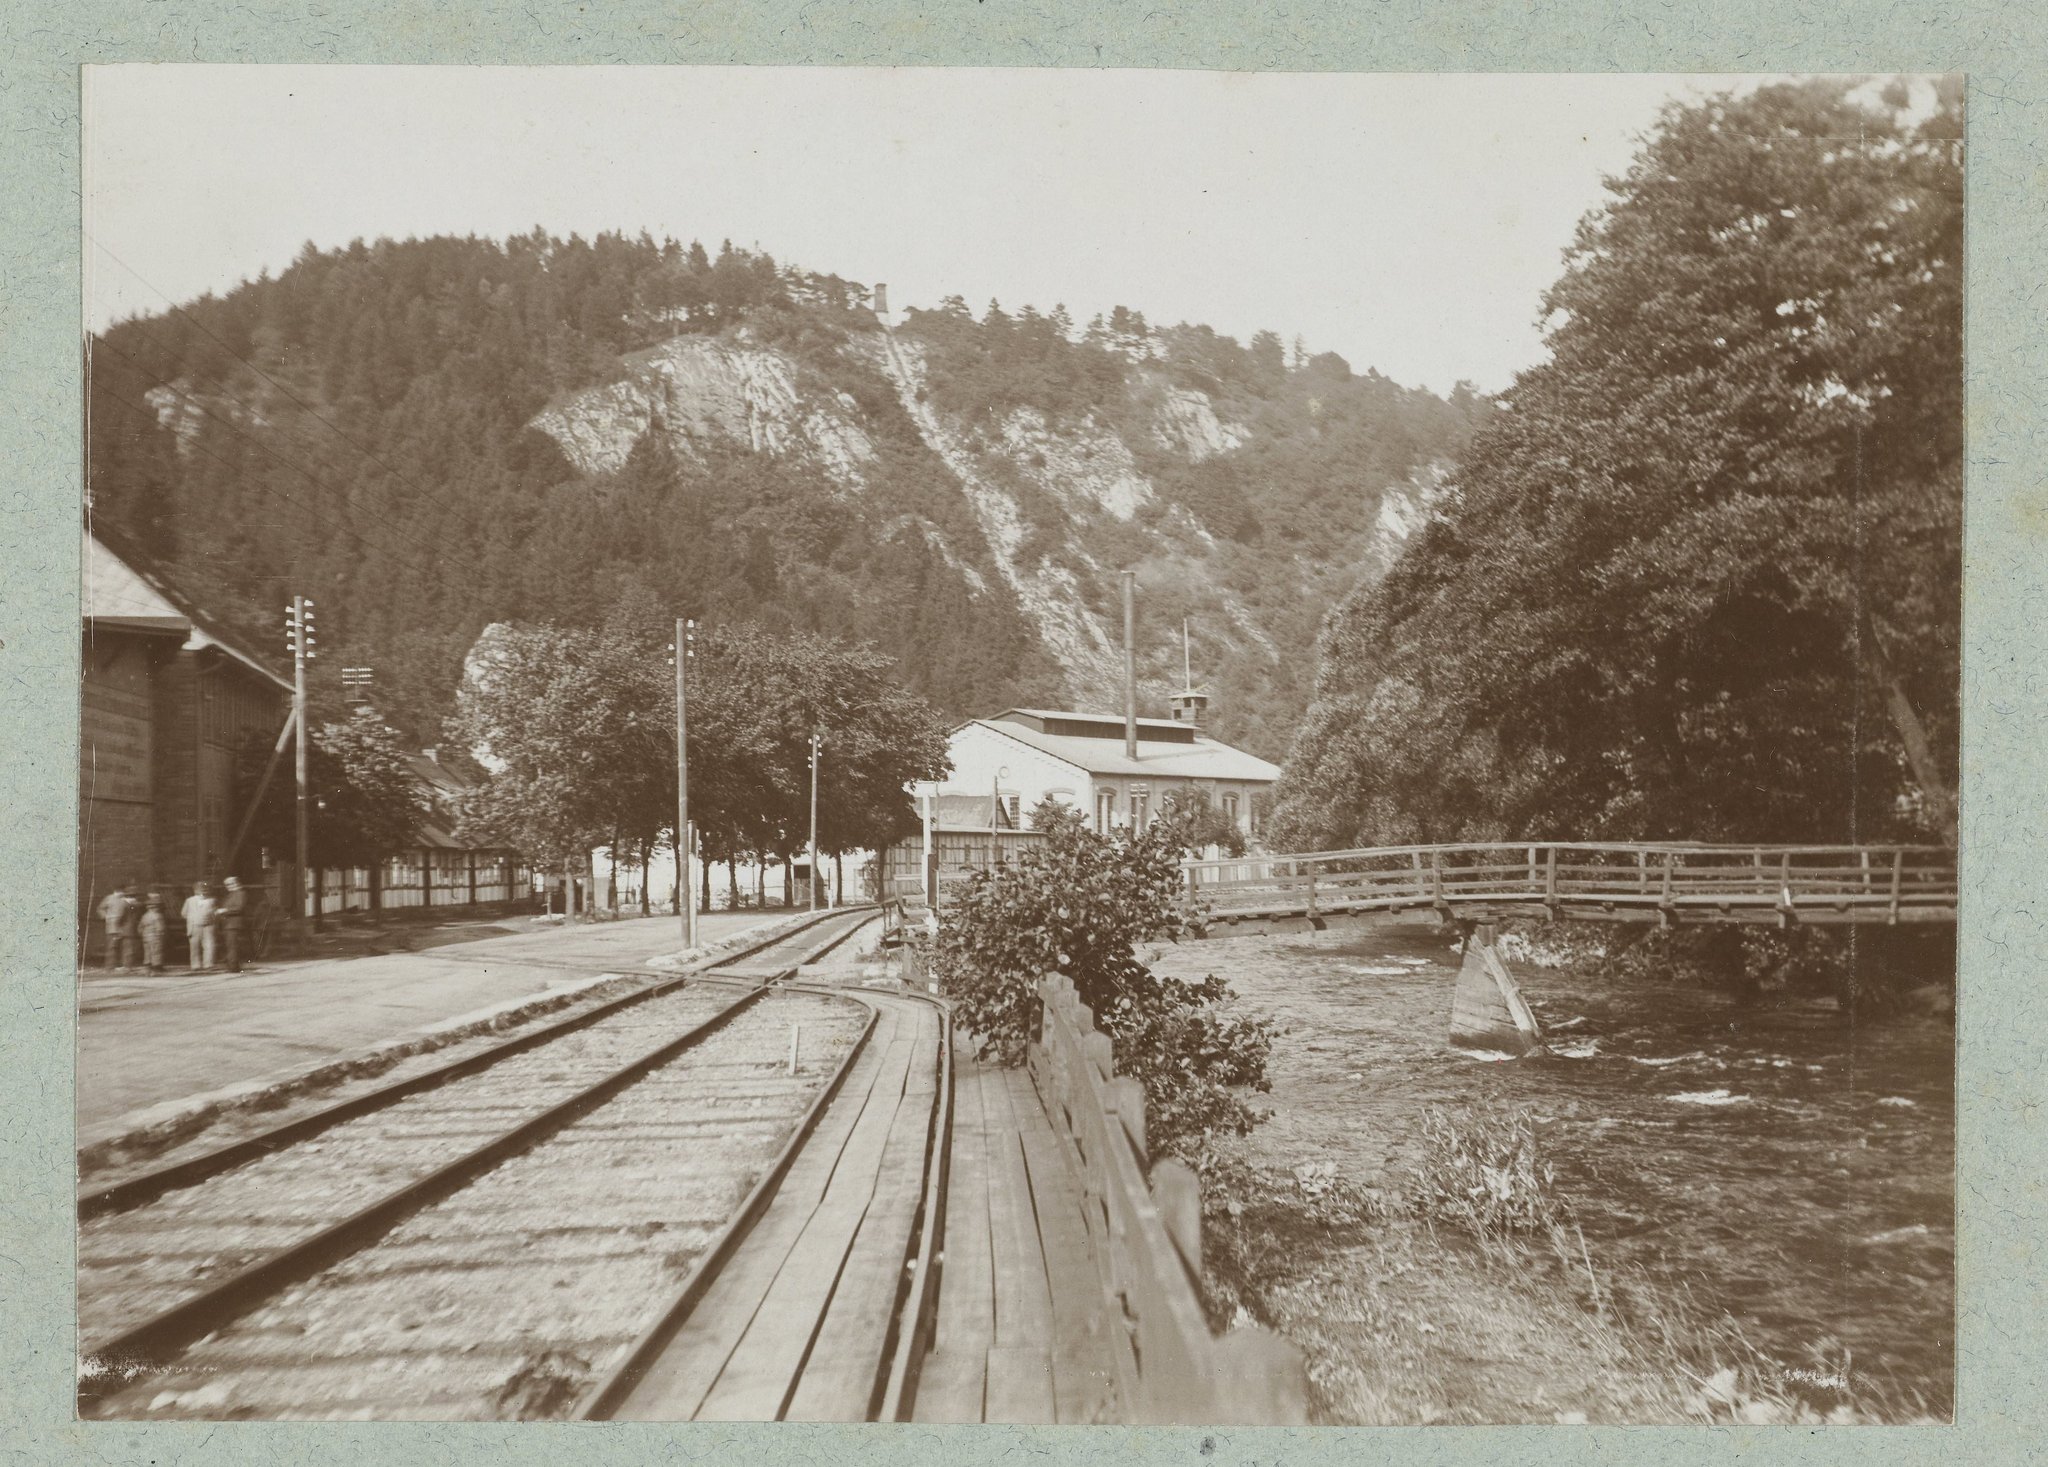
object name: photograph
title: Photographieën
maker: frits freerks fontein fz.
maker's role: fotograaf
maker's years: 1882-1928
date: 1903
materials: cardboard, paper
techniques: gelatin silver print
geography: netherlands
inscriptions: caption: ‘Harz 1905, Rübeland’